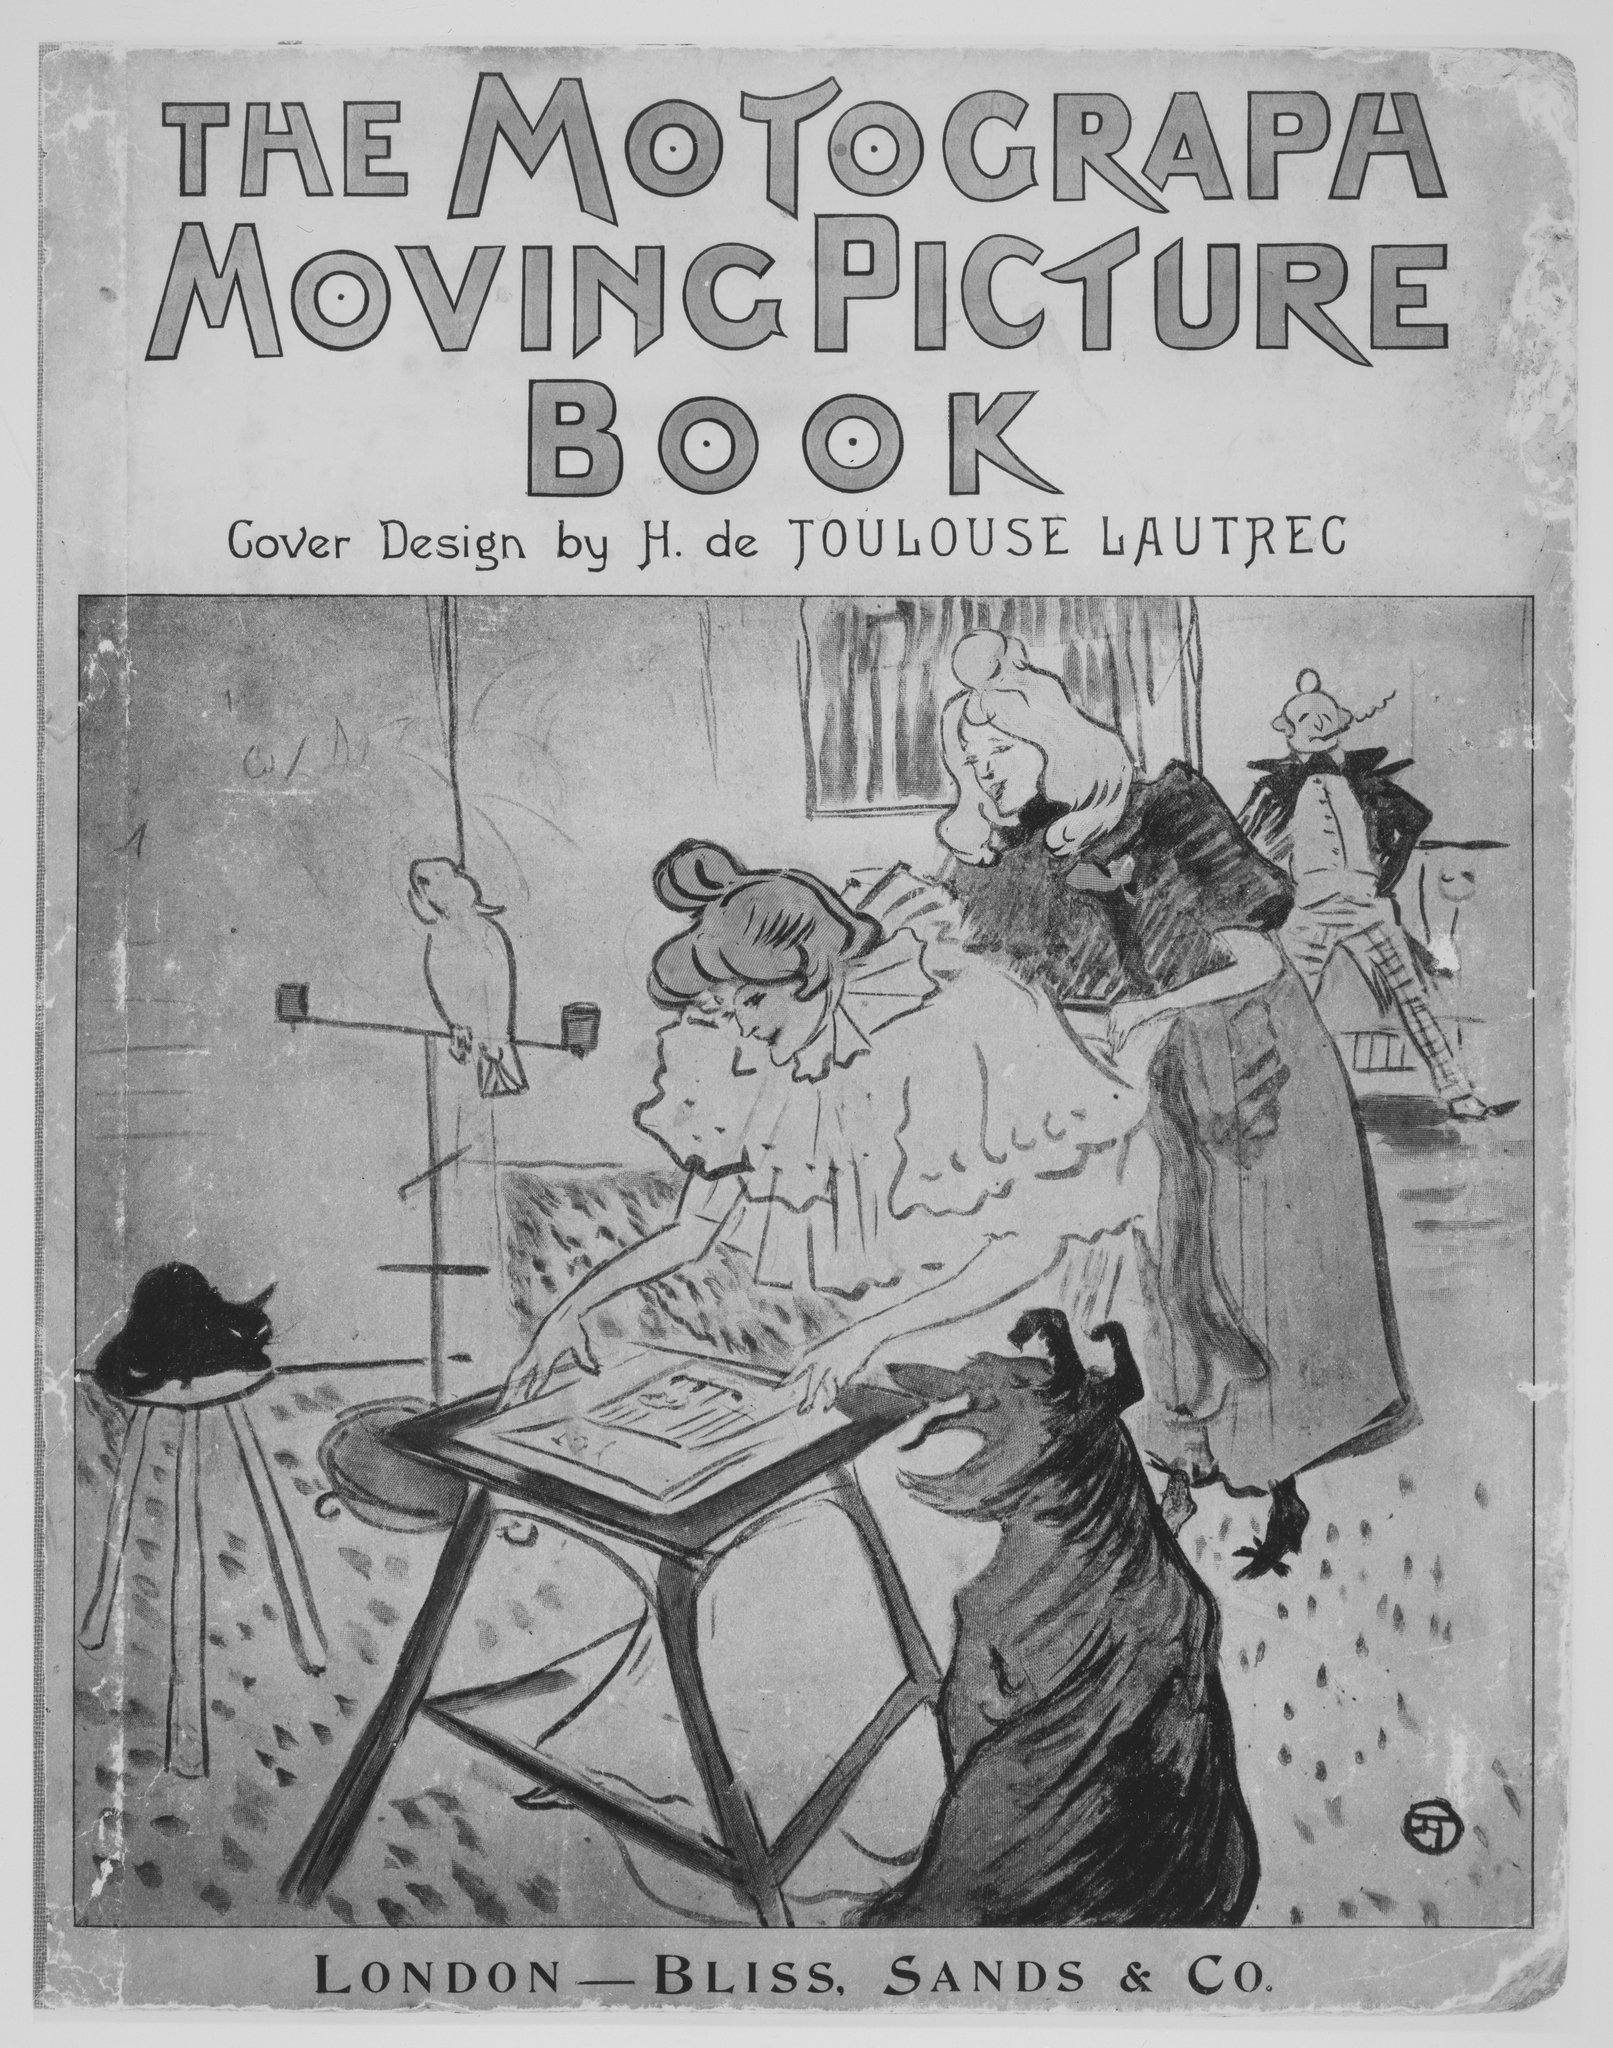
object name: book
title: The Motograph Moving Picture Book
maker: henri de toulouse-lautrec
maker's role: designer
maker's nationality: french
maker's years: 1864-1901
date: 1898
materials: wood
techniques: engraving, lithograph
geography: france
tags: birds,books,men,women,dogs